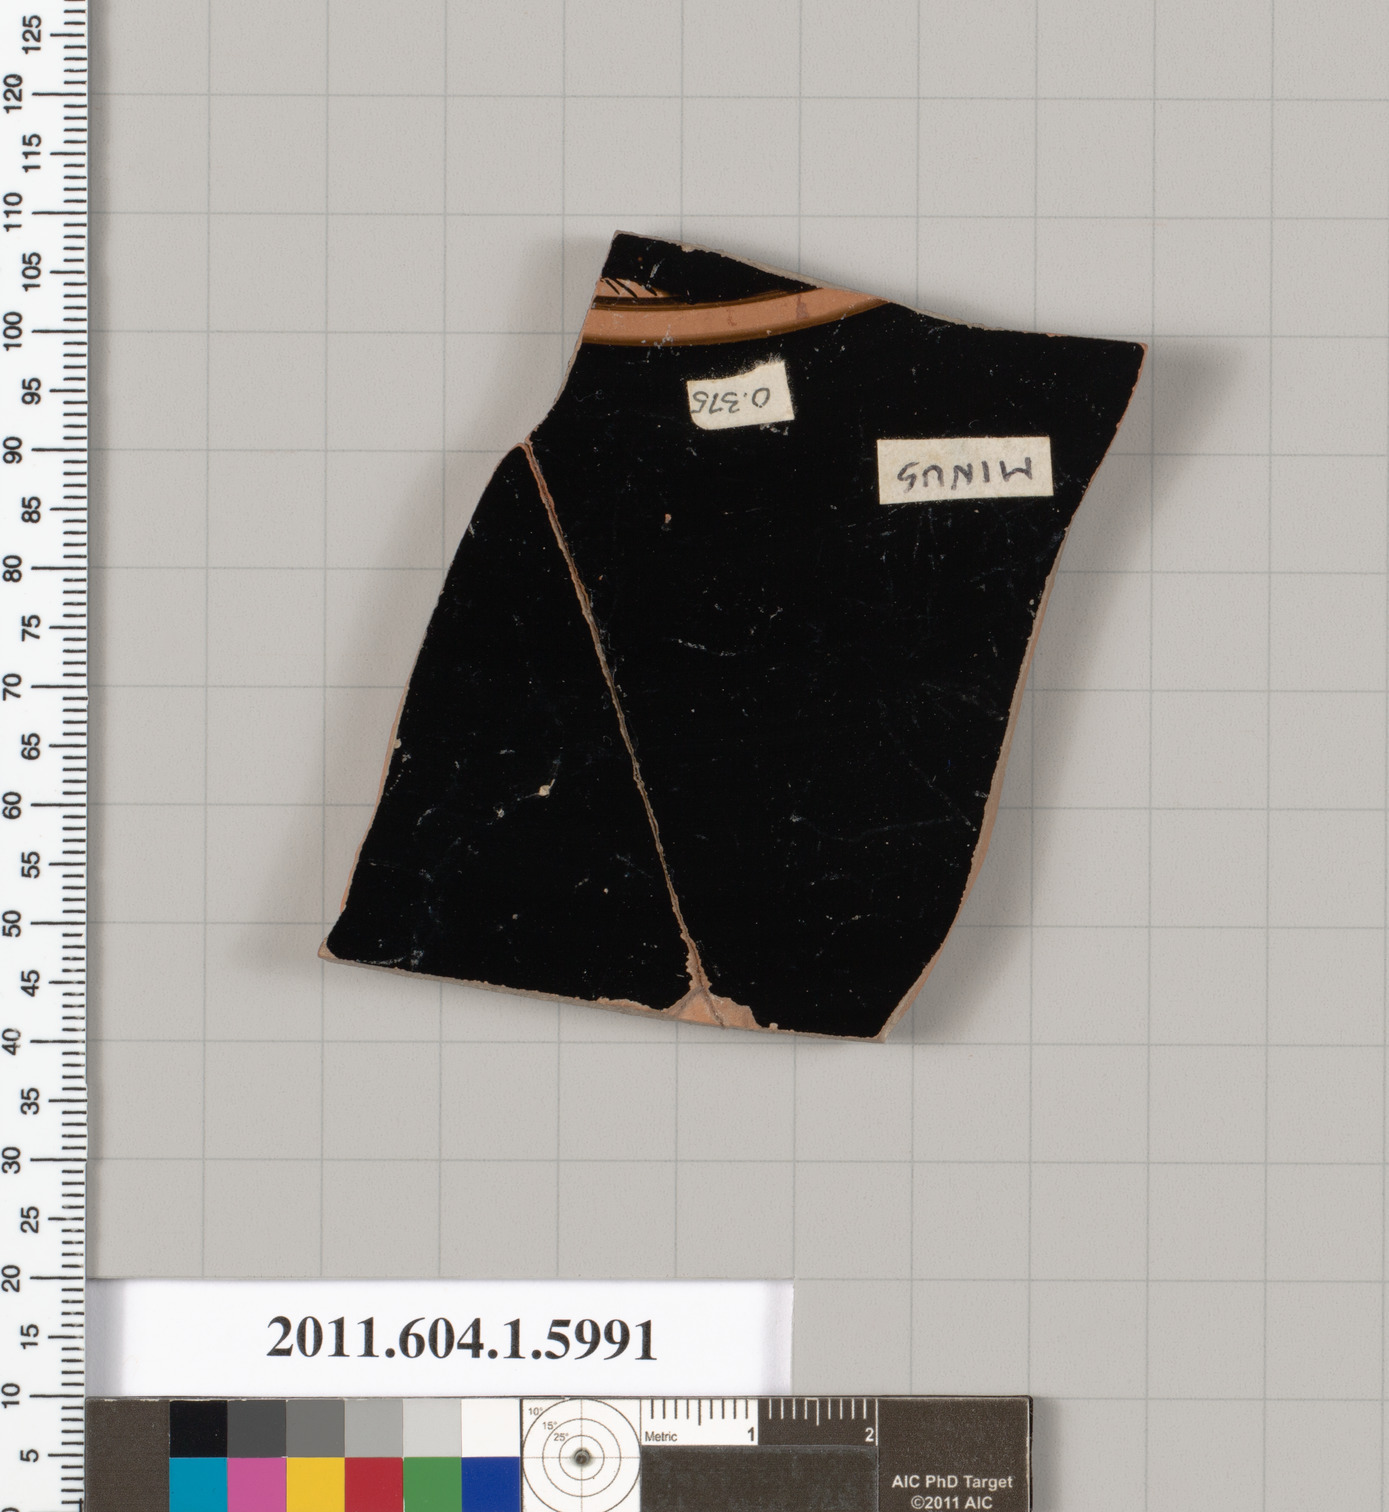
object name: kylix fragment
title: Terracotta fragment of a kylix (drinking cup)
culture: greek, attic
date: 510-500 BCE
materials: terracotta